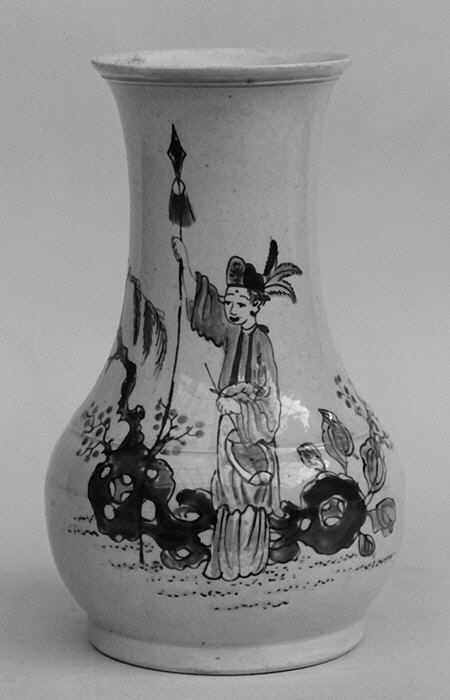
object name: spill vase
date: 1750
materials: stoneware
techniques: salt glaze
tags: chinoiserie,women